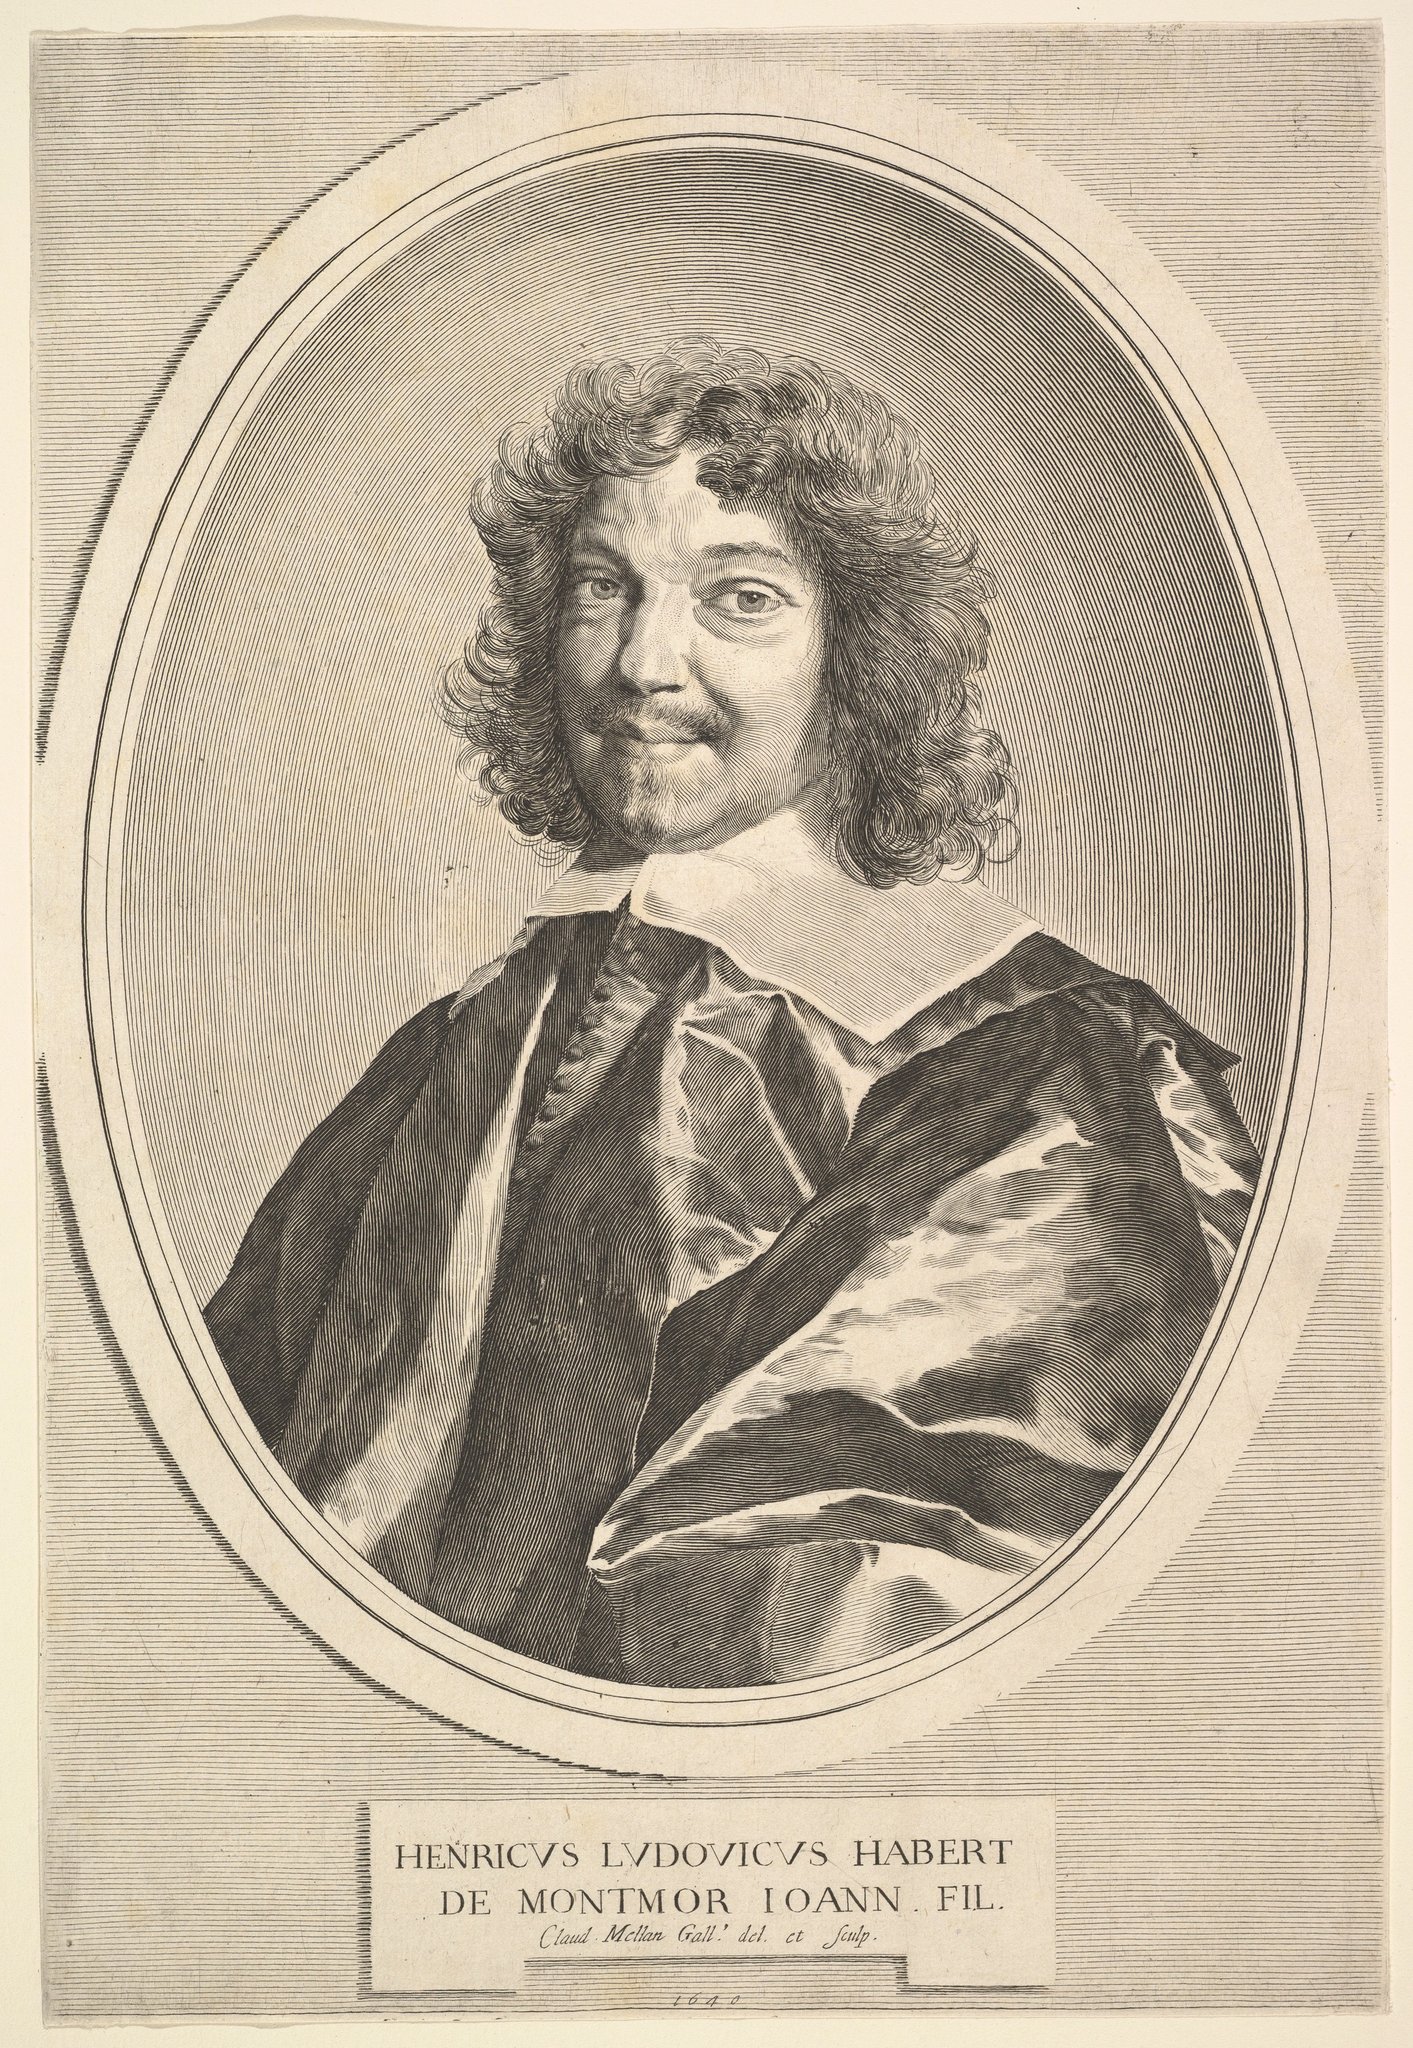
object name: print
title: Henri-Louis Habert de Montmor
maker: claude mellan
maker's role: artist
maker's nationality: french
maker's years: 1598-1688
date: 1640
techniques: engraving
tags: men,portraits